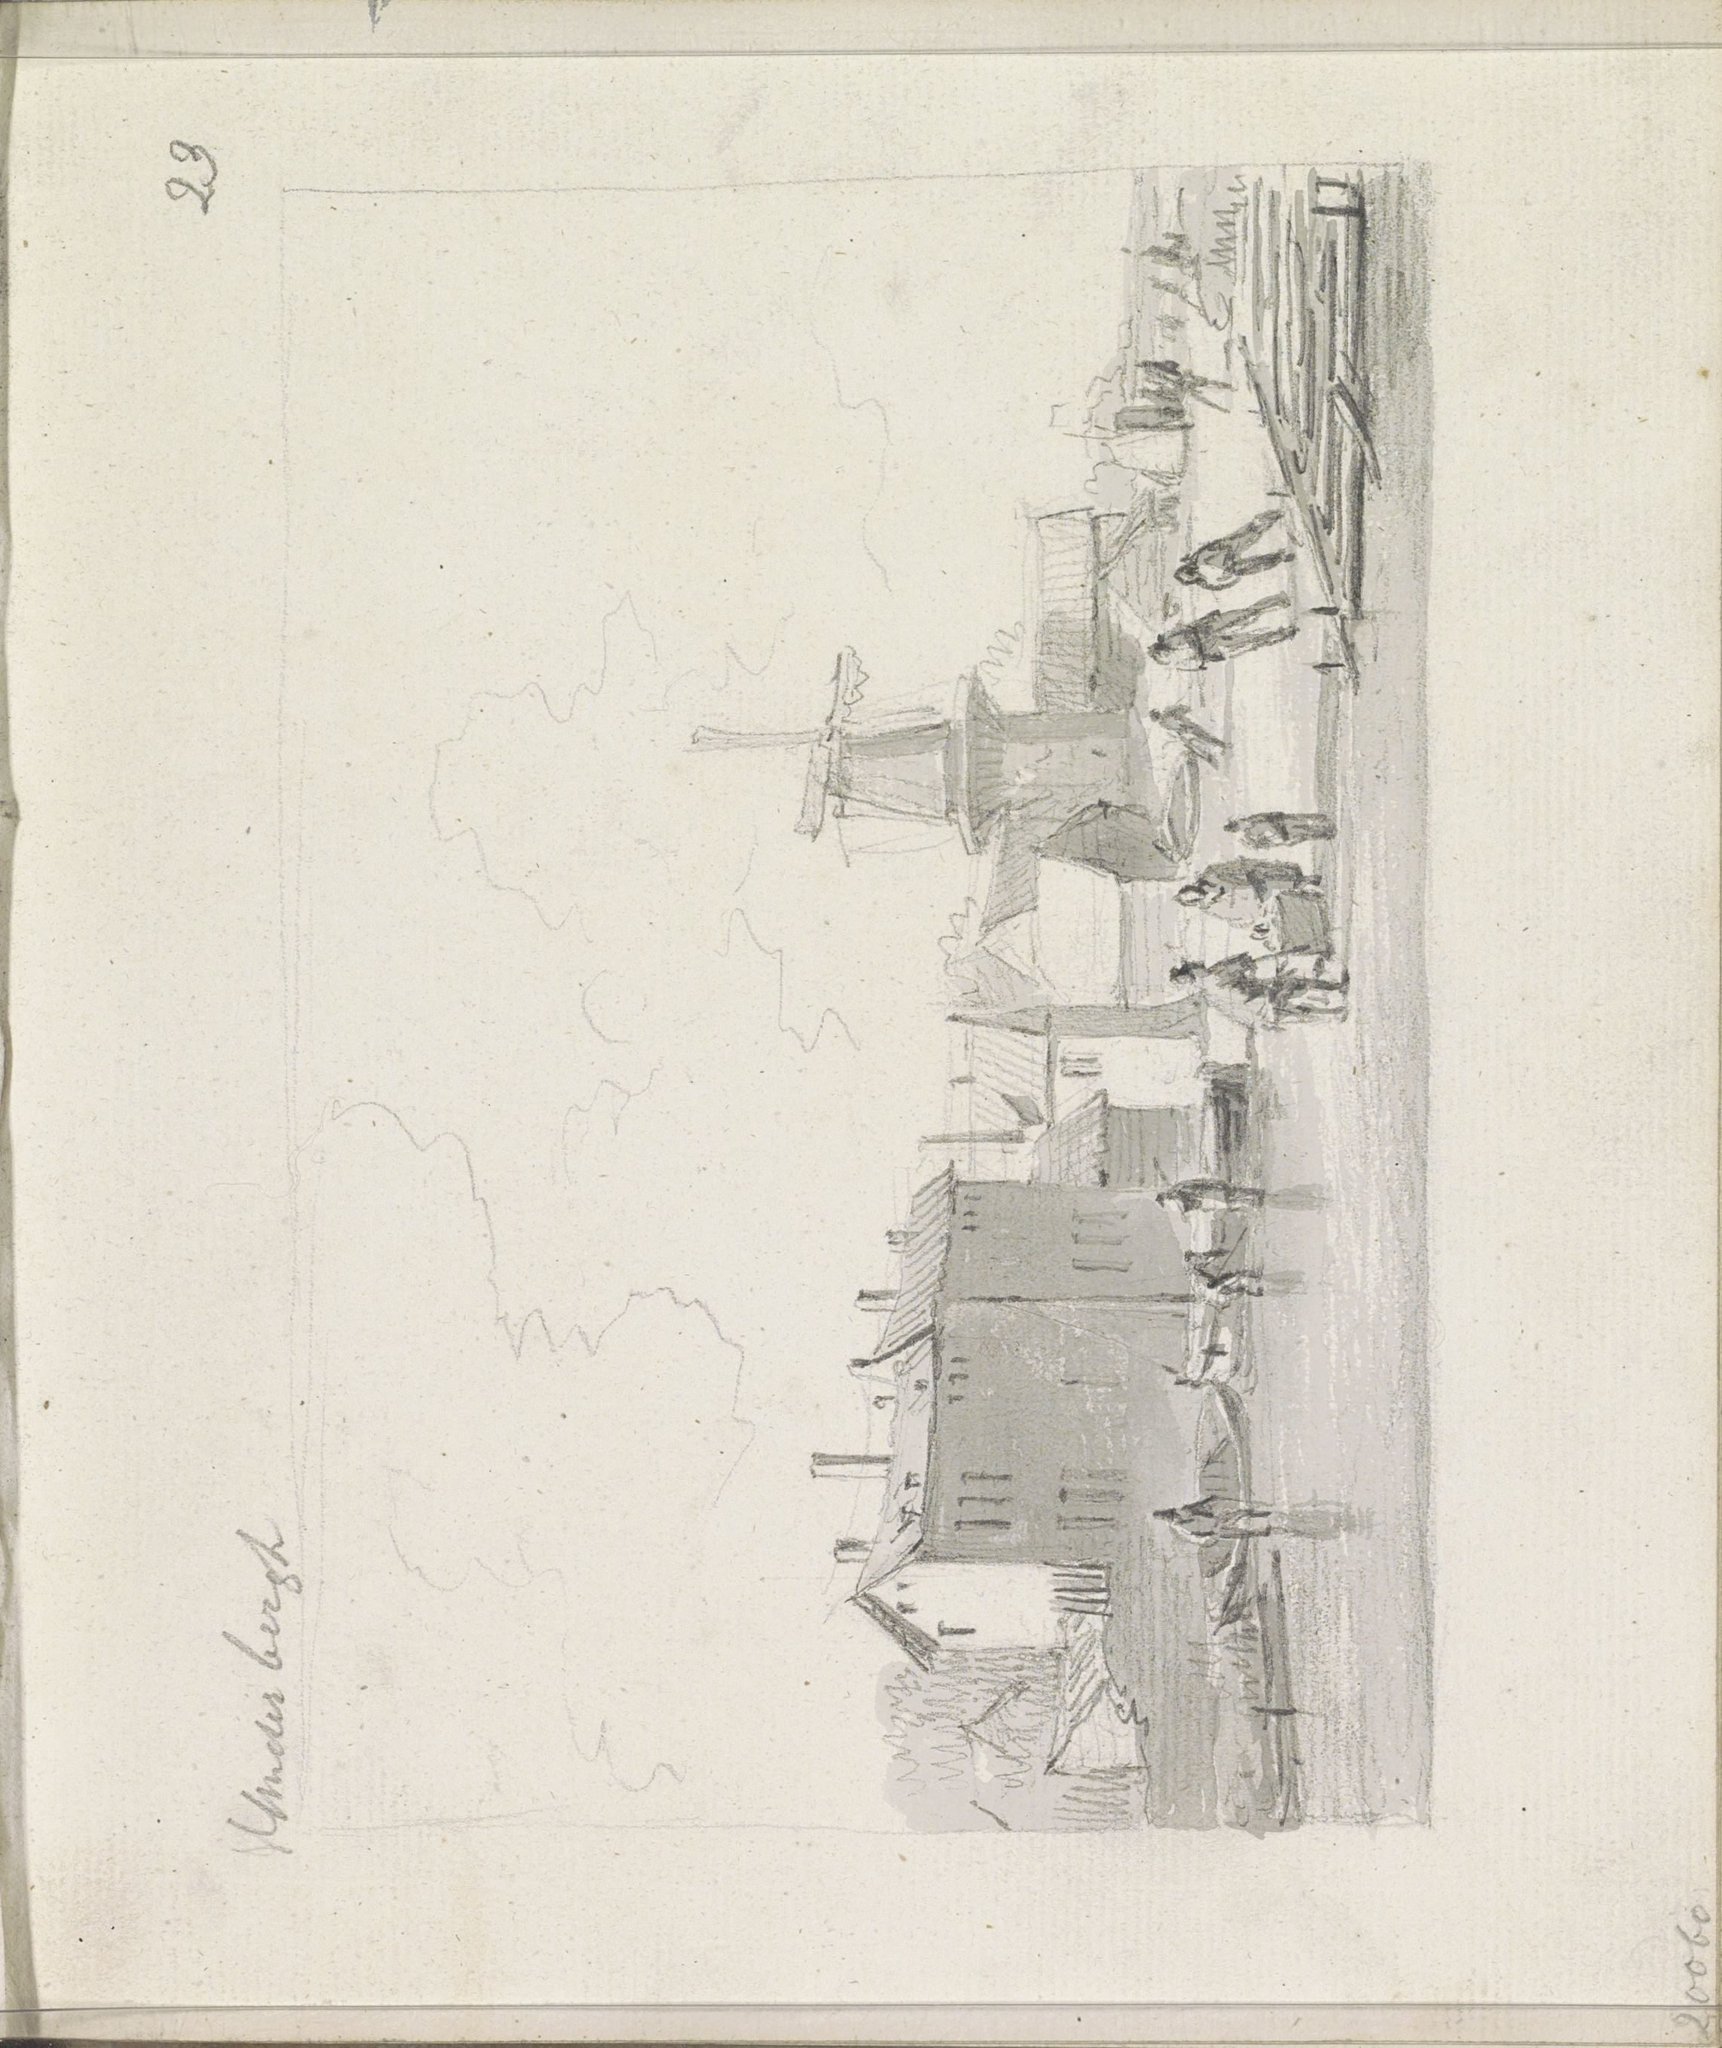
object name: sketchbook leaf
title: Schaatsers bij een molen aan de rand van een dorp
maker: andreas schelfhout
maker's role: draughtsman, painter, print maker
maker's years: 1787-1870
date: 1825-1829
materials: paper, pencil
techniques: brush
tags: frost, freezing weather, windmill, village (+ city(-scape) with figures, staffage)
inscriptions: number: ‘23/ 20060’, annotation: ‘Van der bergh’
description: Blad 37 recto uit een schetsboek met 95 bladen.